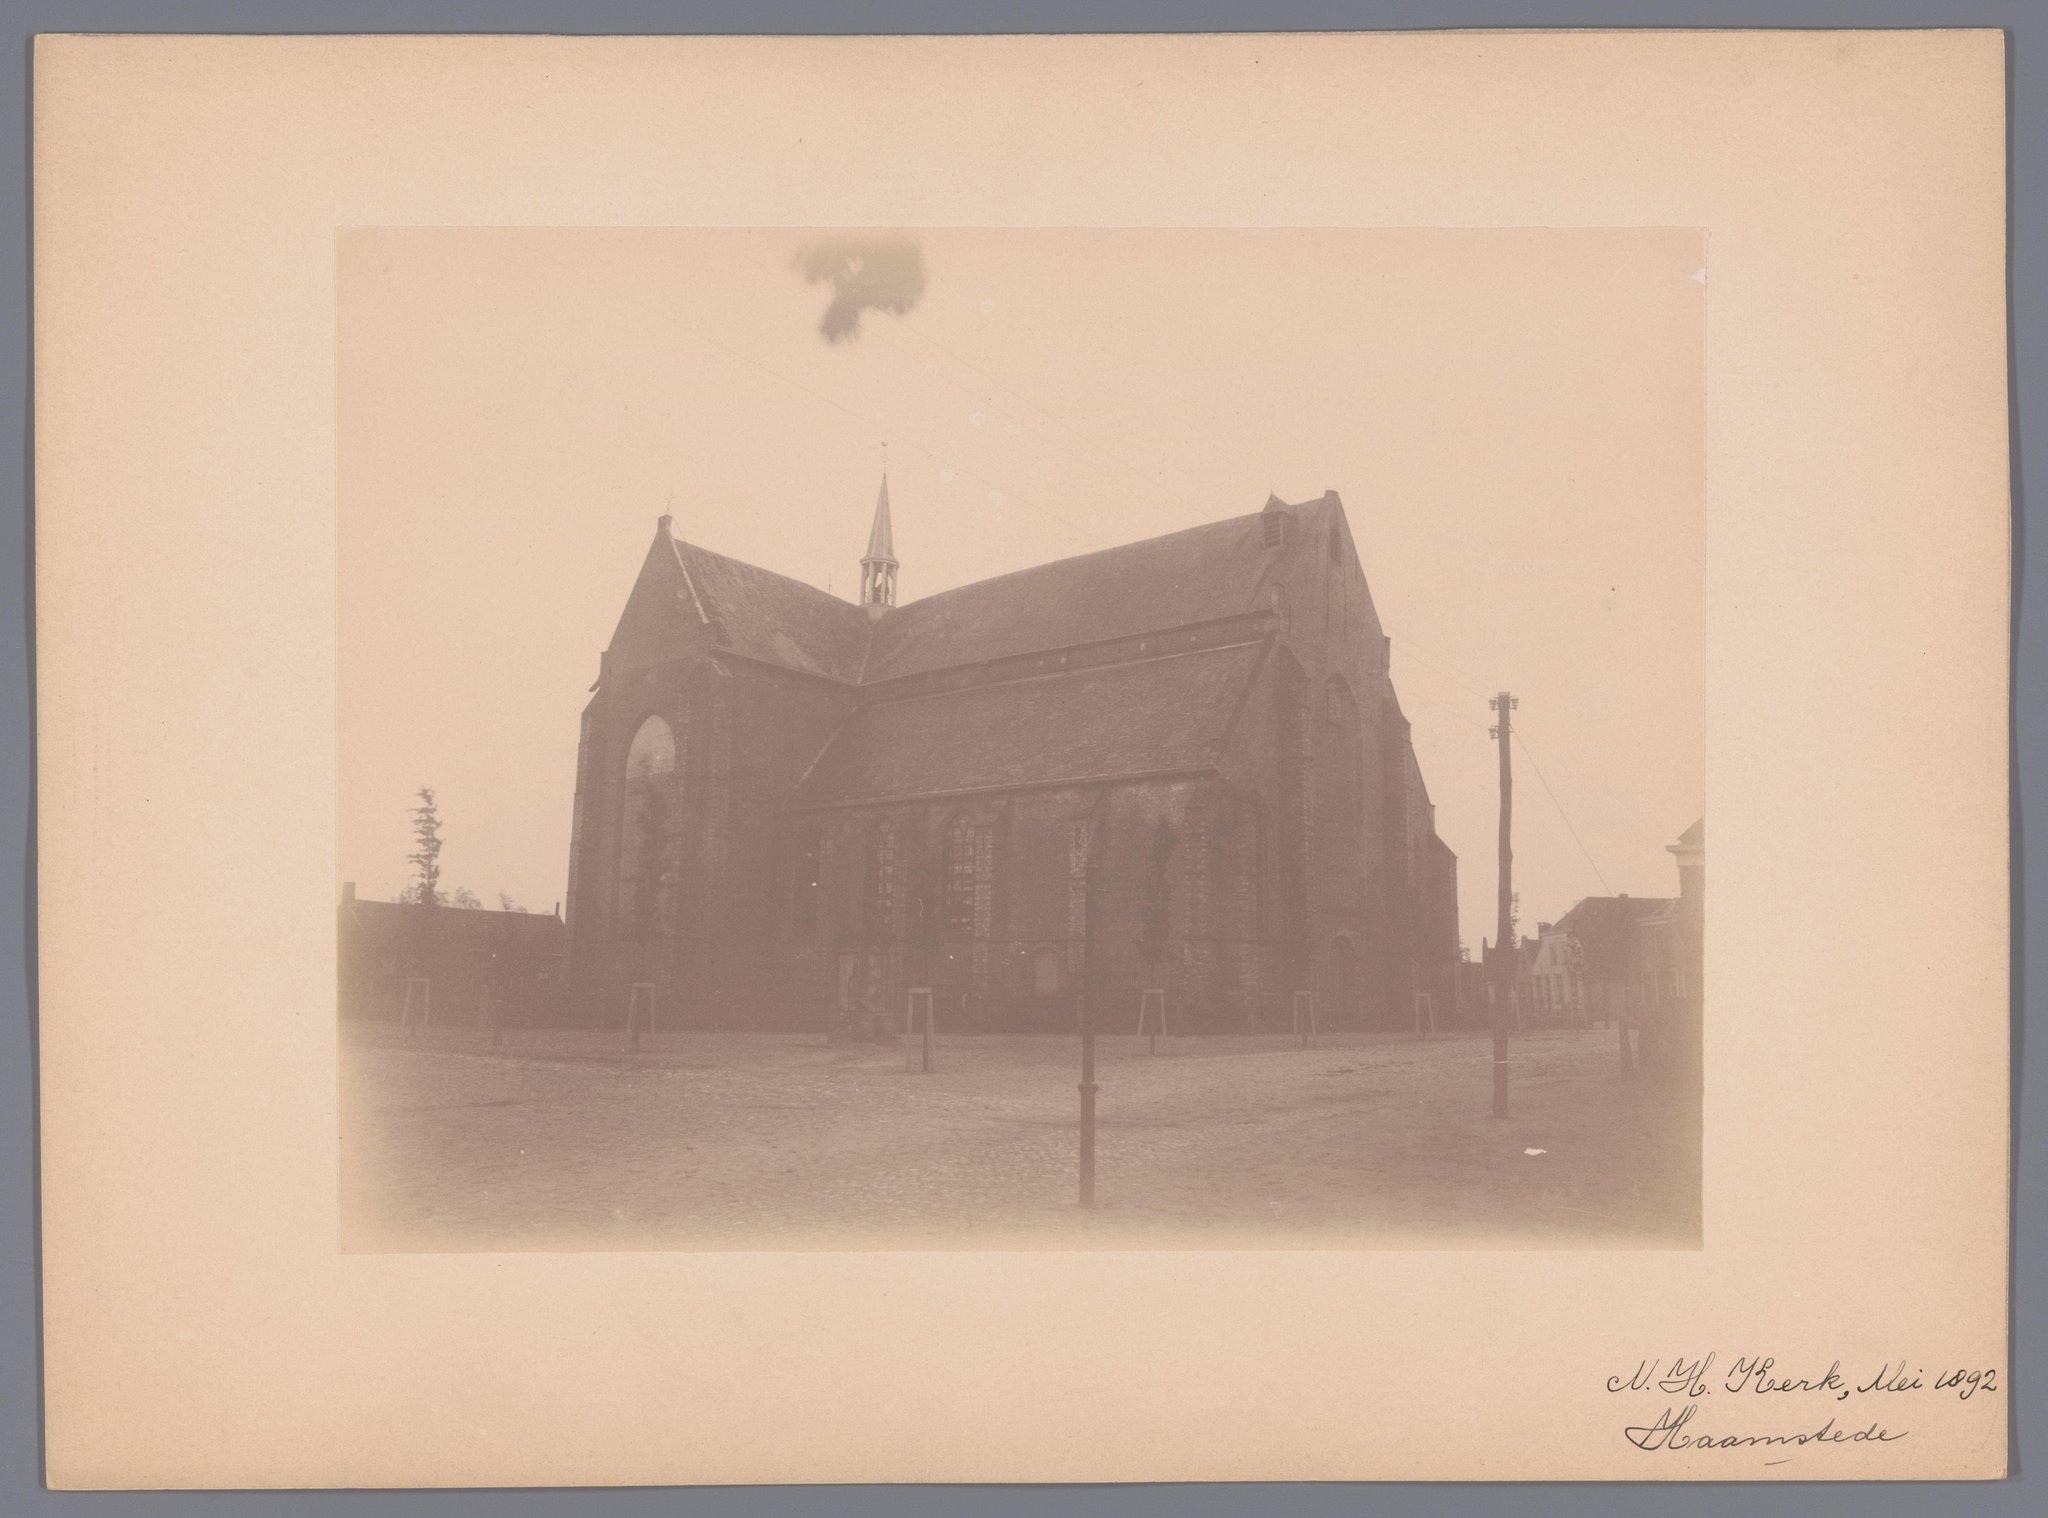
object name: photograph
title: Gezicht op de Hervormde Kerk te Haamstede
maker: anoniem (monumentenzorg)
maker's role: fotograaf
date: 1892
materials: cardboard, photographic support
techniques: albumen print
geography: haamstede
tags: church (exterior)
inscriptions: annotation: ‘N.H. Kerk, Mei 1892/ Haamstede’, annotation: ‘Kerk v/d N.H. gemeente te Haamstede (schouwen) Zeeland/ Mei 1892’